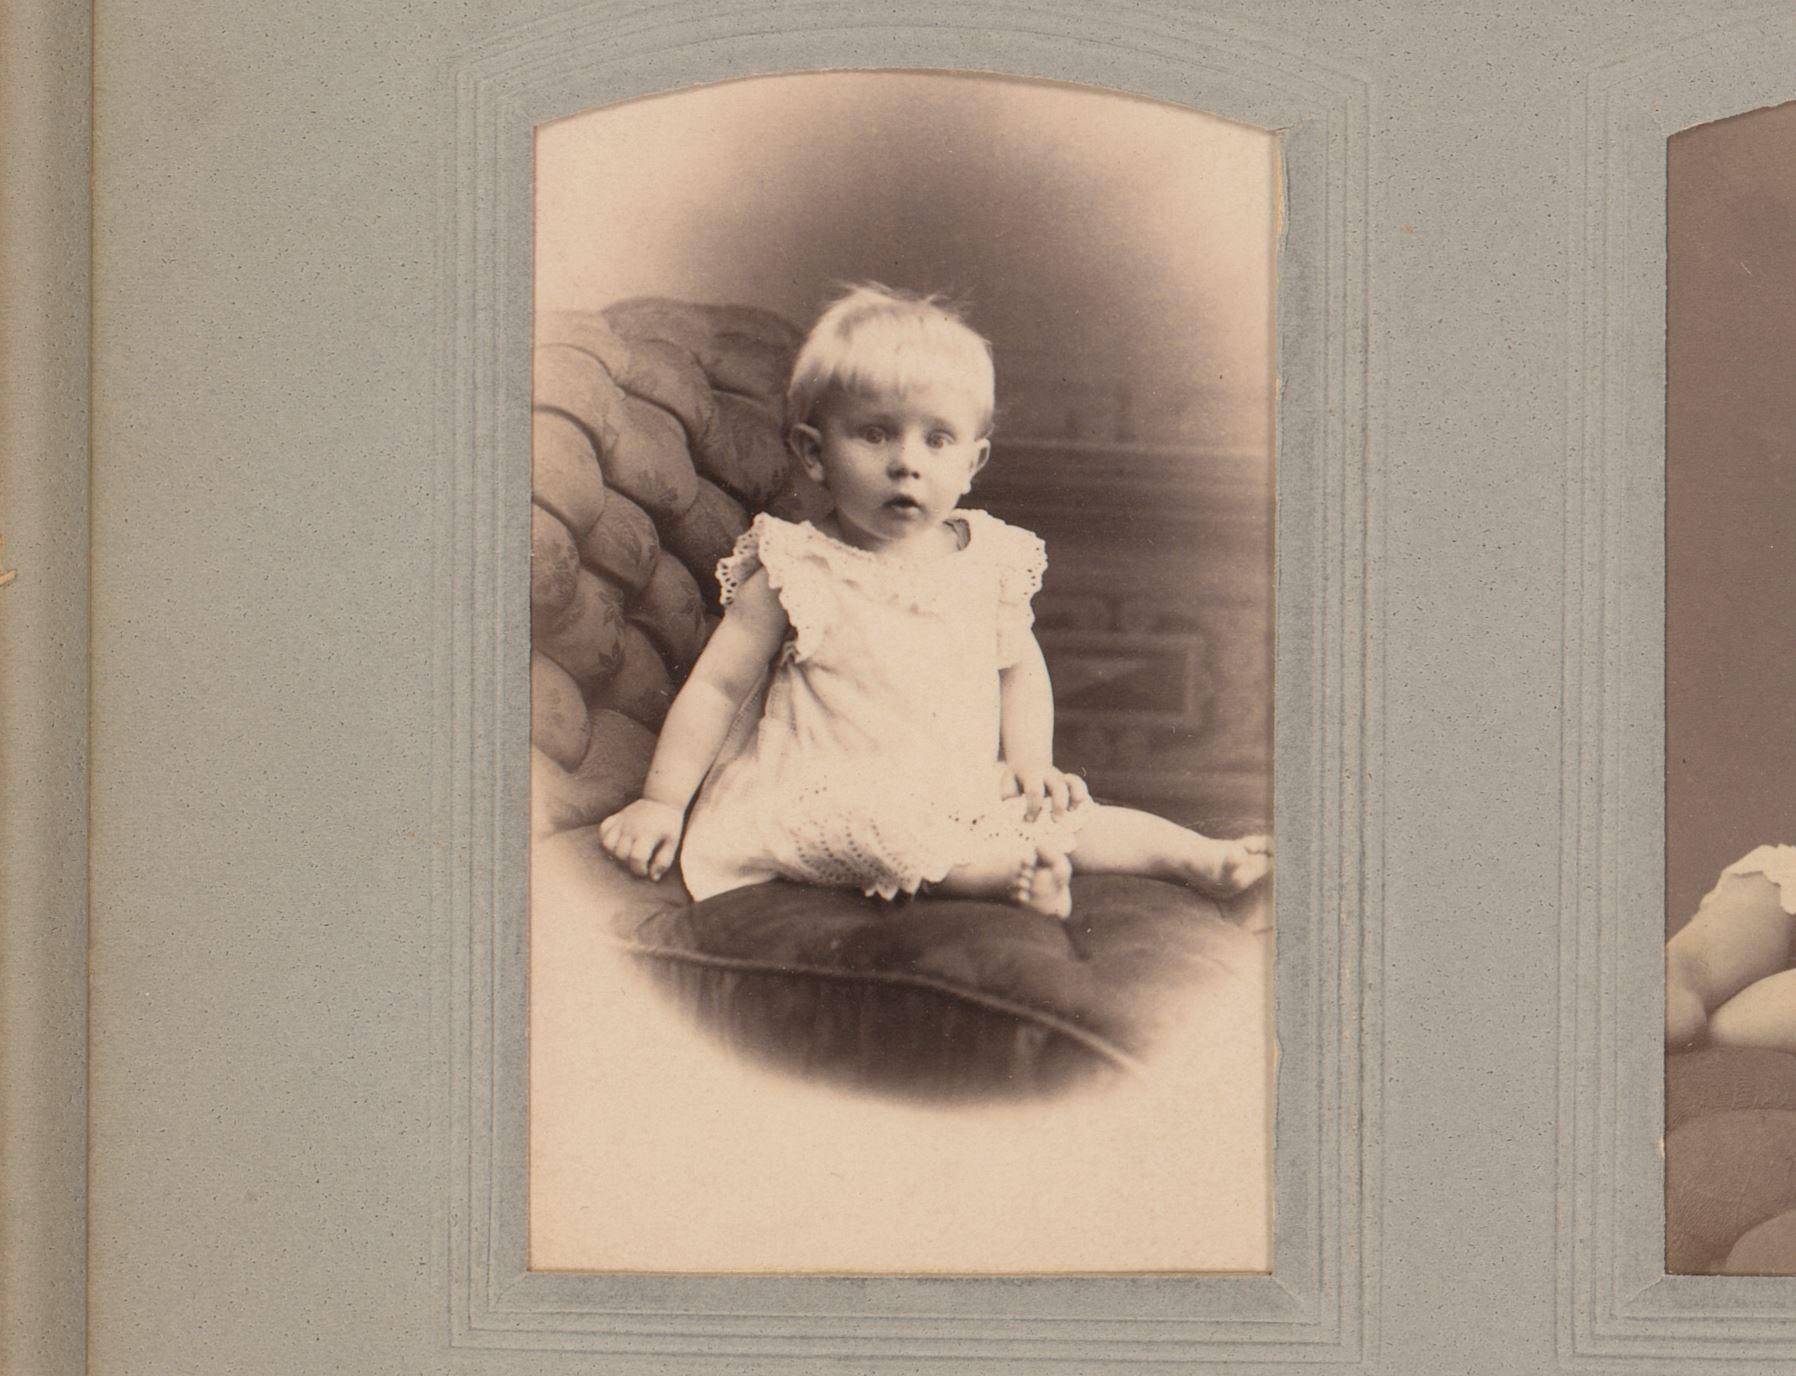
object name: album leaf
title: Portret van een zittend kind in witte jurk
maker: axel rydin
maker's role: fotograaf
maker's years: 1837-1912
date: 1870-1900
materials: cardboard, photographic support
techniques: albumen print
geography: stockholm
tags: sitting figure, historical persons, tot, toddler ~ the ages of man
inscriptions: inscription: ‘A. Rydin/ Stockholm/ Mästersamuelsgatan 51 C./ Plåten förvaras för efterbeställning.’